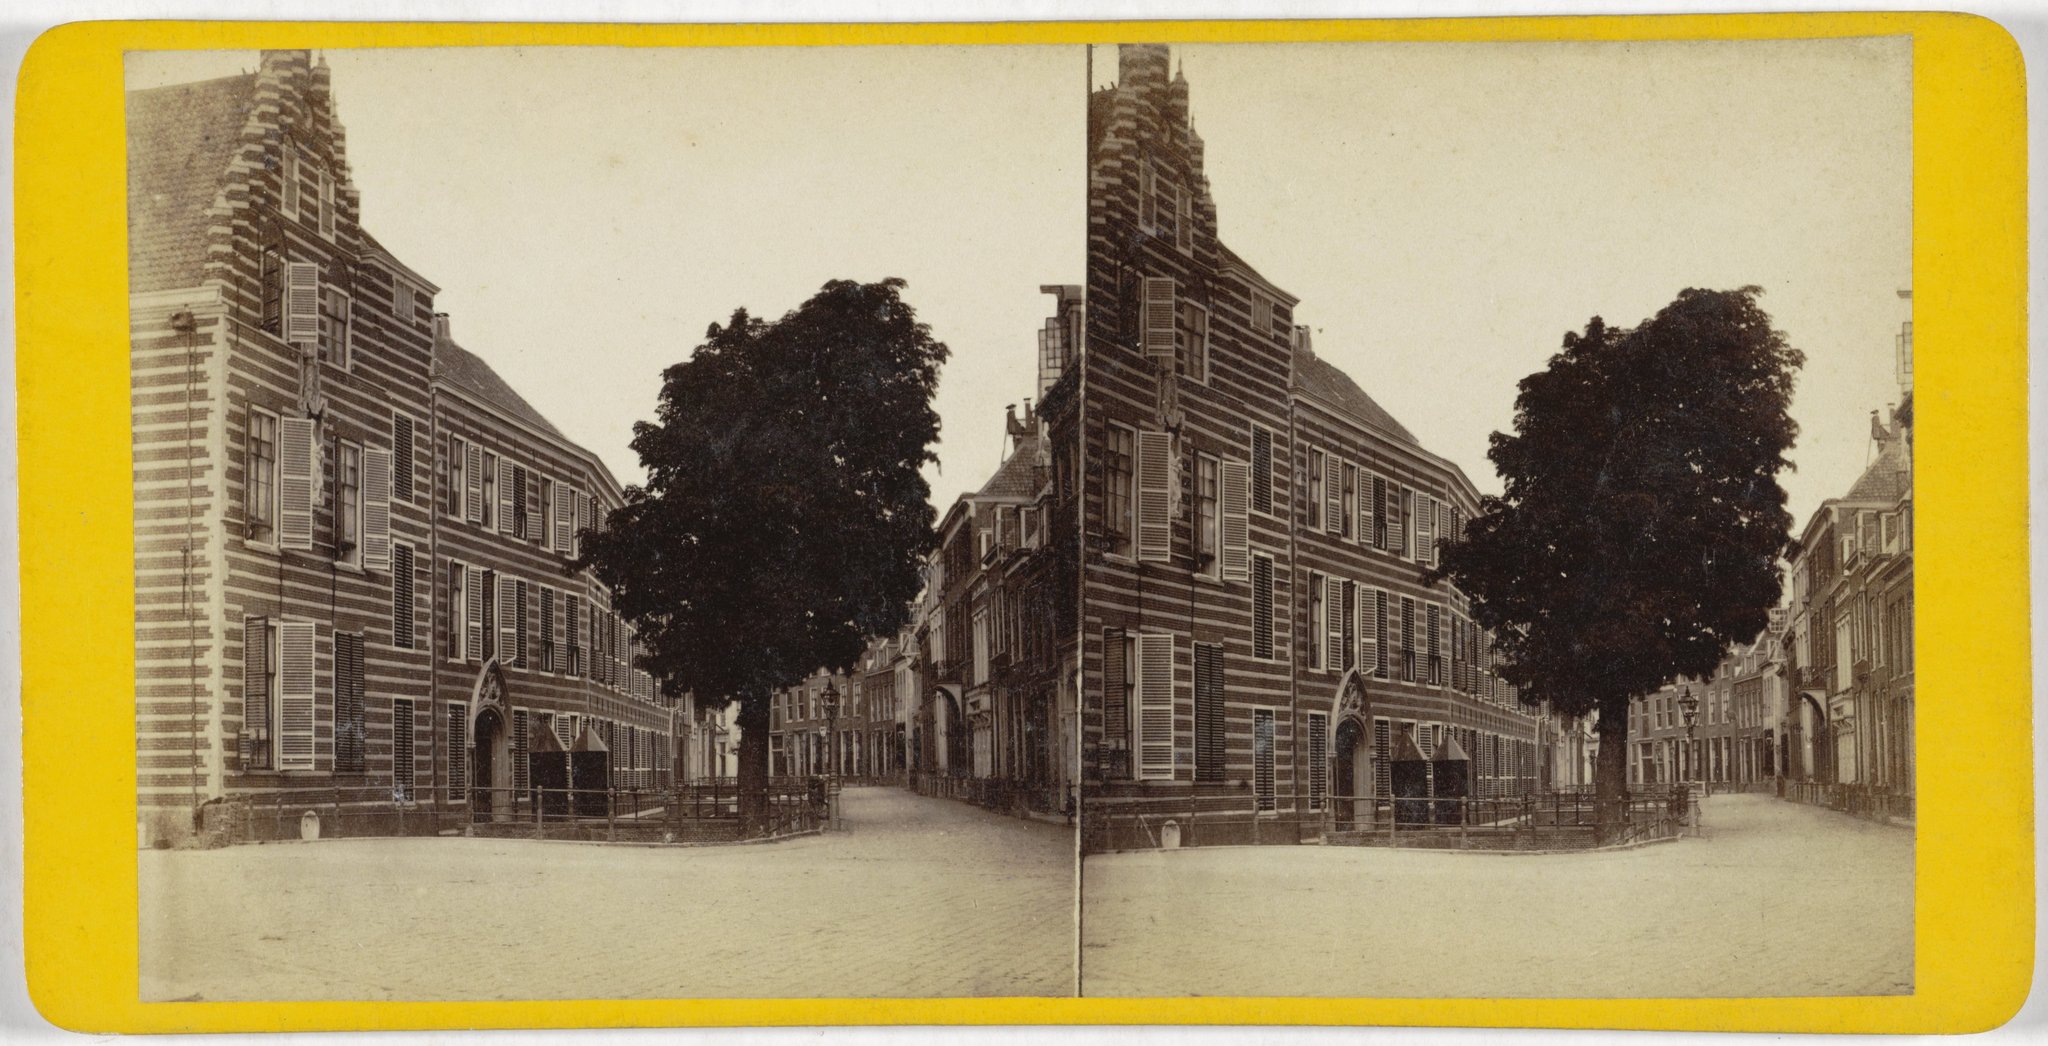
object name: stereograph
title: Paushuize, Utrecht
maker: Anonymous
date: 1873-1890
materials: cardboard, paper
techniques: albumen print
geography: utrecht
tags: urban housing, street